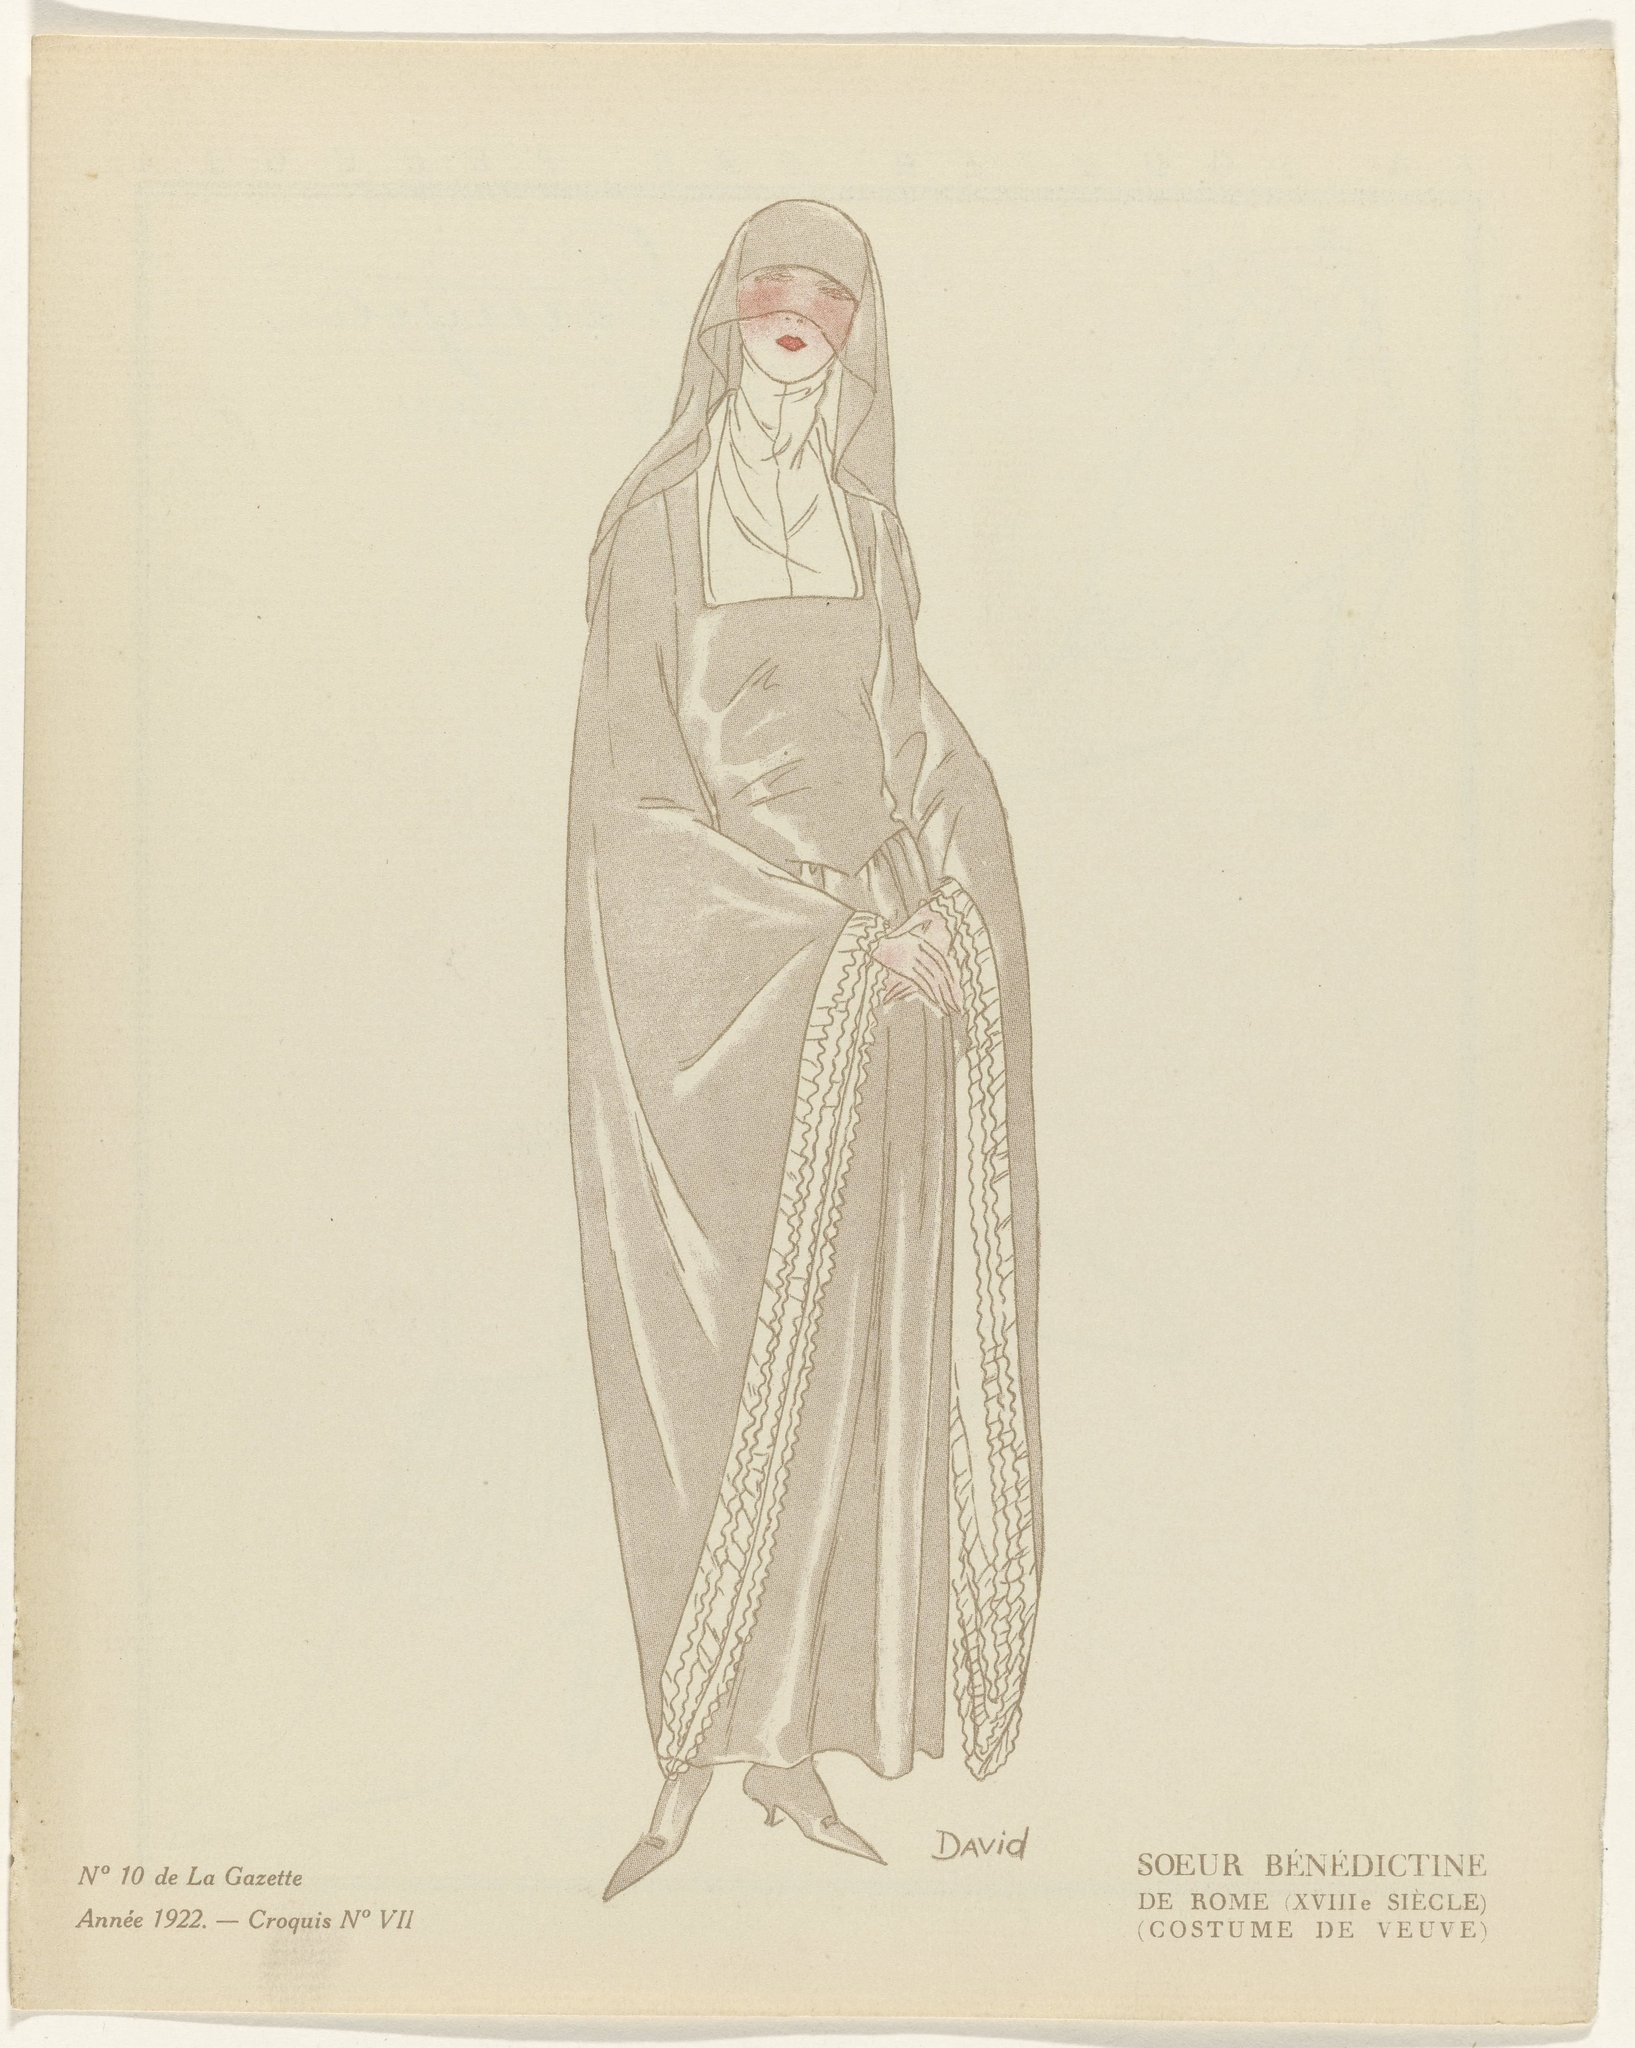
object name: fashion print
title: Gazette du Bon Ton, 1922 - No. 10, Pl. VII : Soeur Bénédictine / De Rome (XVIIIe siècle) / (Costume de veuve)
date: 1922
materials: paper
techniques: printing, letterpress printing, photochemical processes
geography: berlin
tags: head-gear (+ women's clothes), fashion plates, dress, gown (+ women's clothes)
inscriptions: date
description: Staande vrouw gekleed in een japon met wijd uitlopende mouwen, afgezet met ruches; geïnspireerd op het ordekleed van een benedictijnse non. Op het hoofd een sluier. Croquis No. VII uit Gazette du Bon Ton 1922, No. 10. Uitleg over de kleding op pagina "Description et explication des planches hors-texte et pages de croquis."